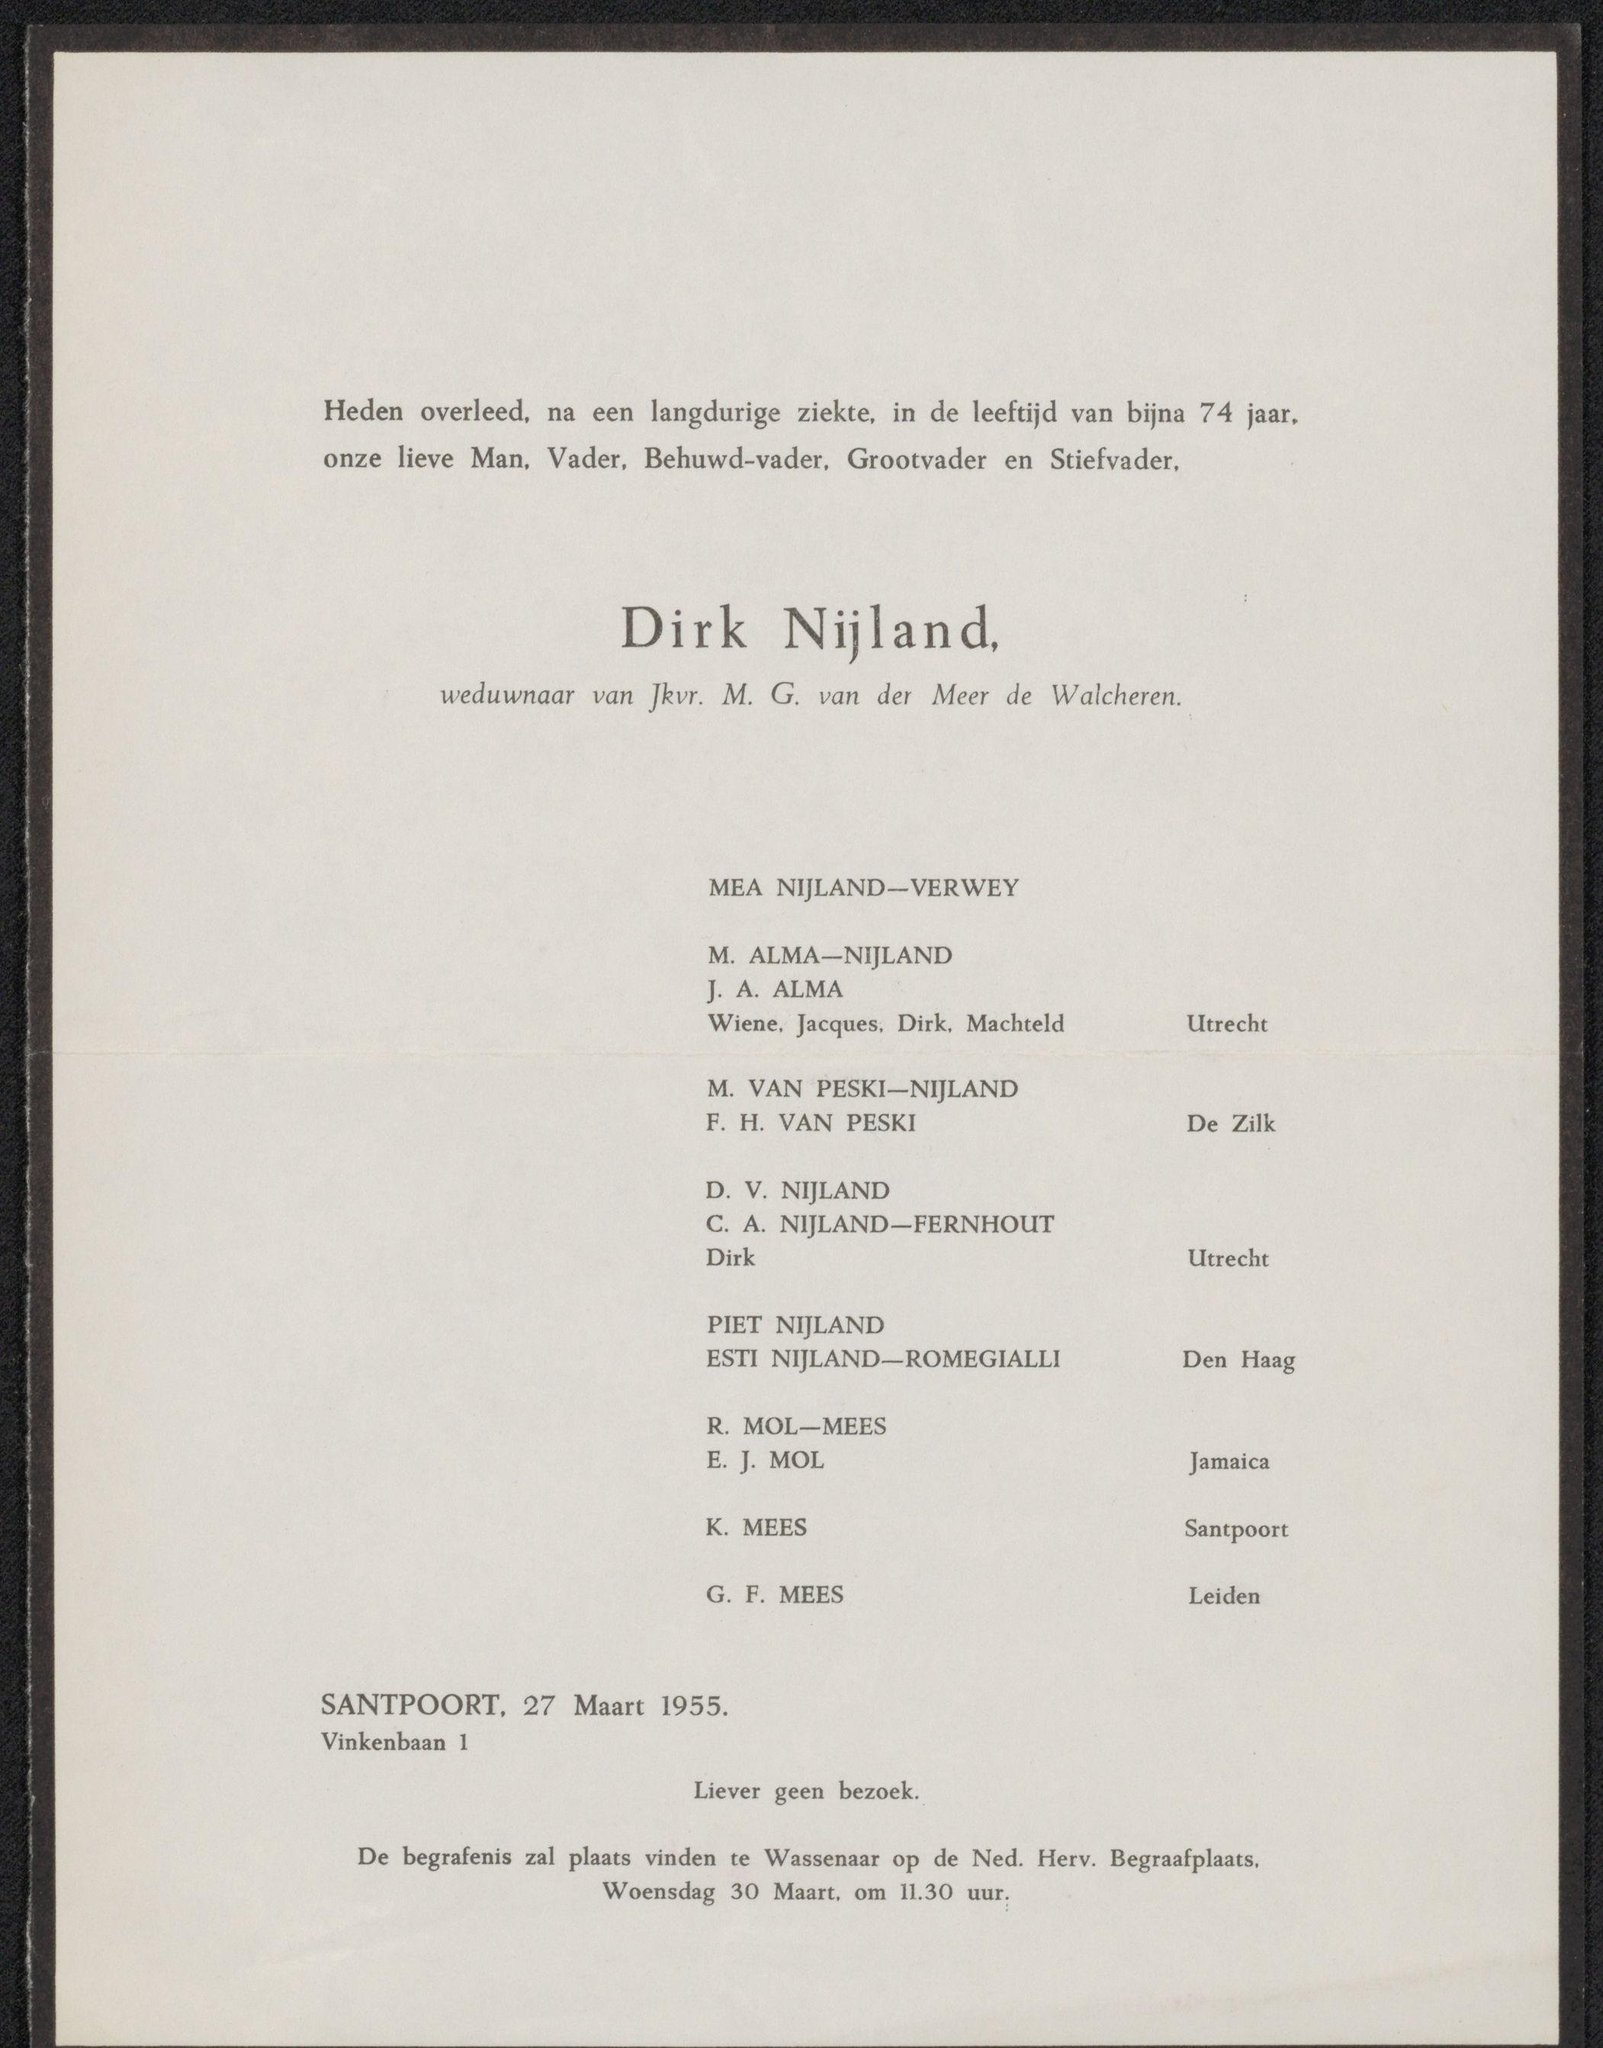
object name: overlijdensbericht, overlijdensadvertentie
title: Overlijdensbericht betreffende Dirk Hidde Nijland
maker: Anonymous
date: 1955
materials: paper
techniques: printing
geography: santpoort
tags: dordrecht, print maker, draughtsman, dirk hidde nijland